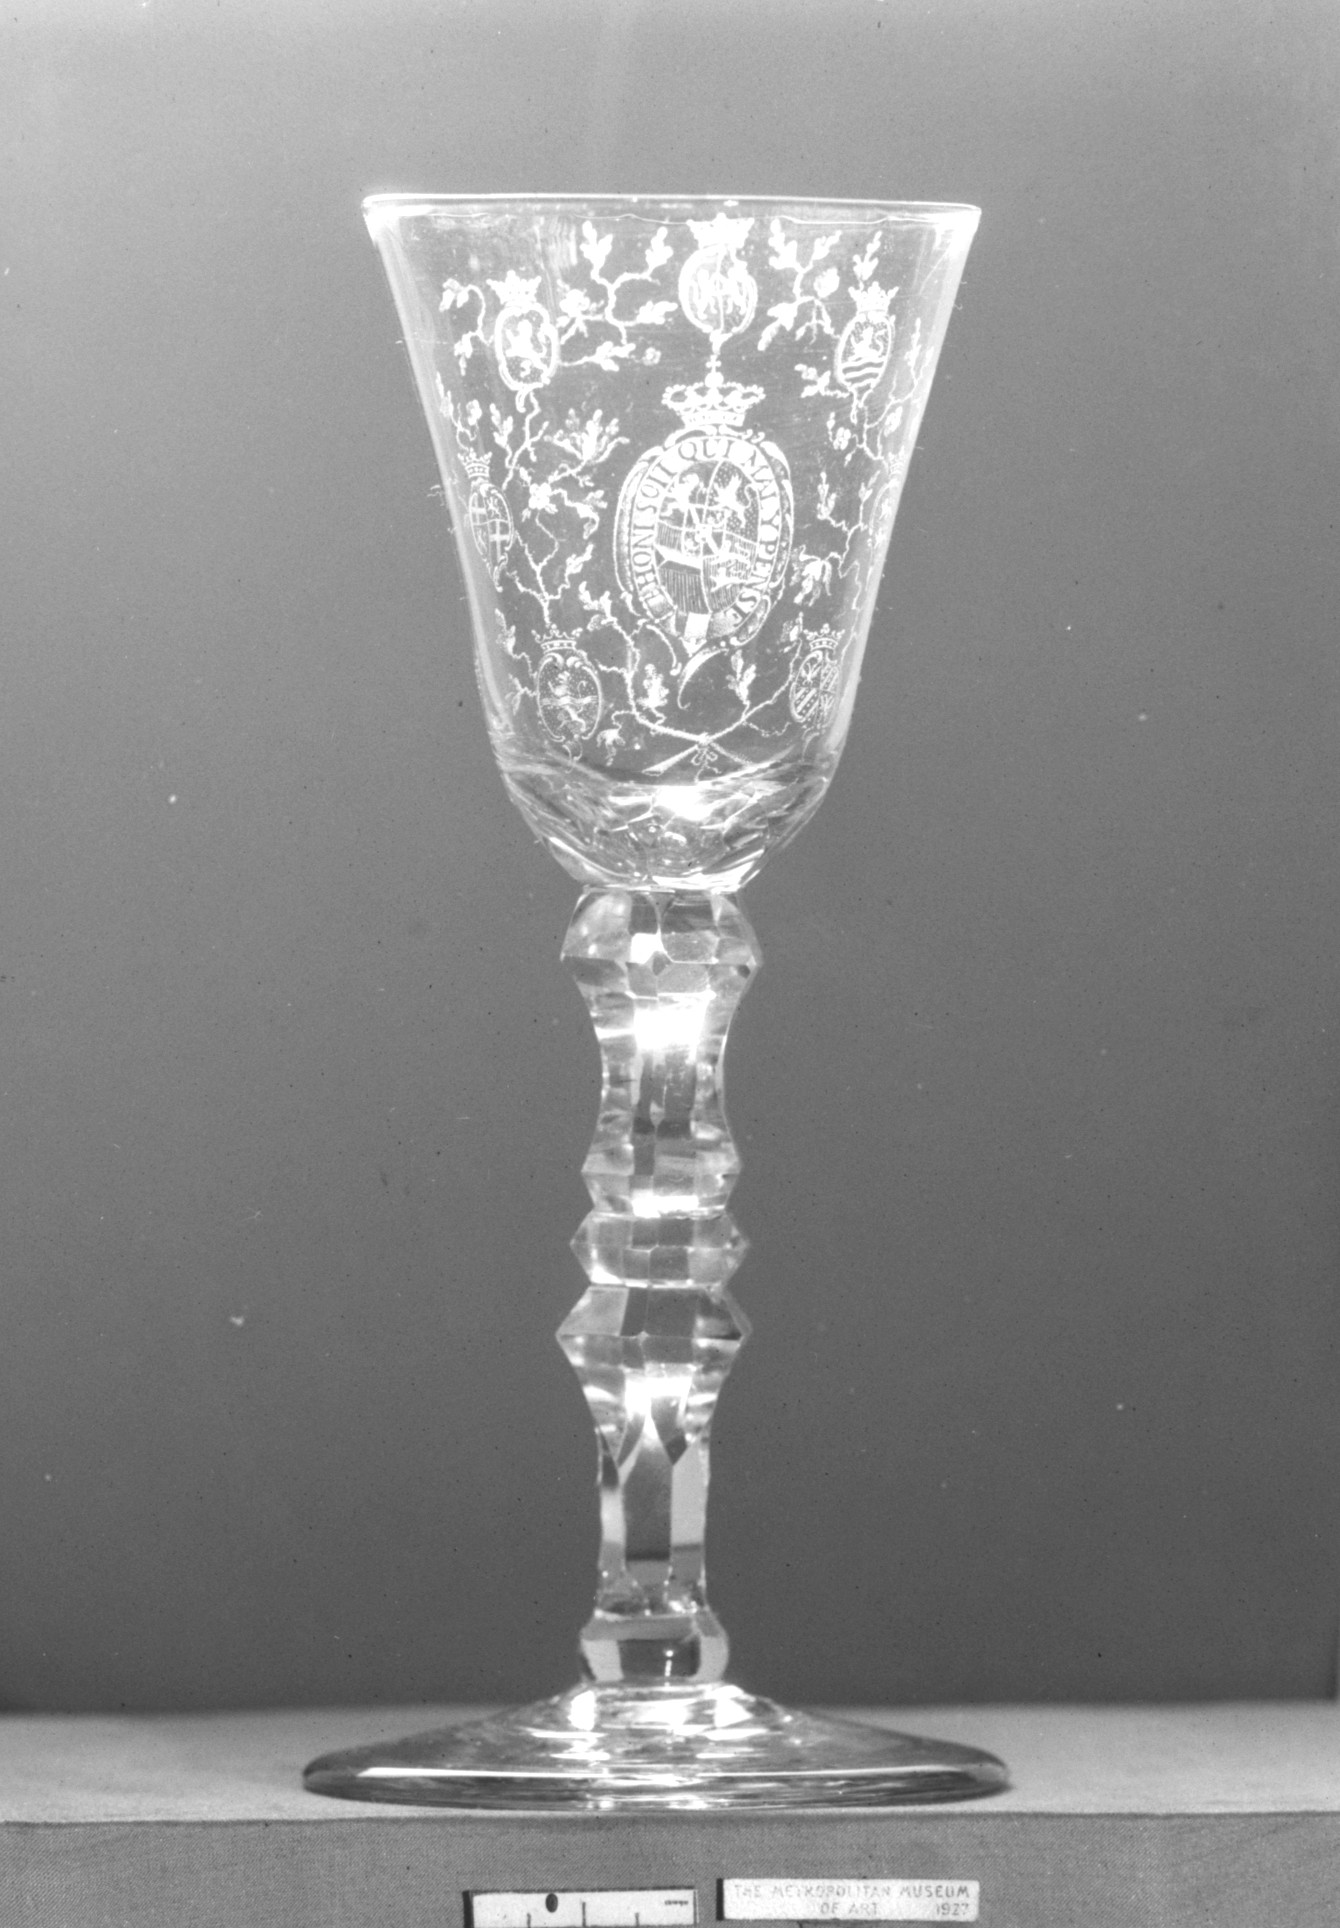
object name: wineglass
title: Wineglass with arms of William V, Prince of Orange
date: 1775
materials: glass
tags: coat of arms